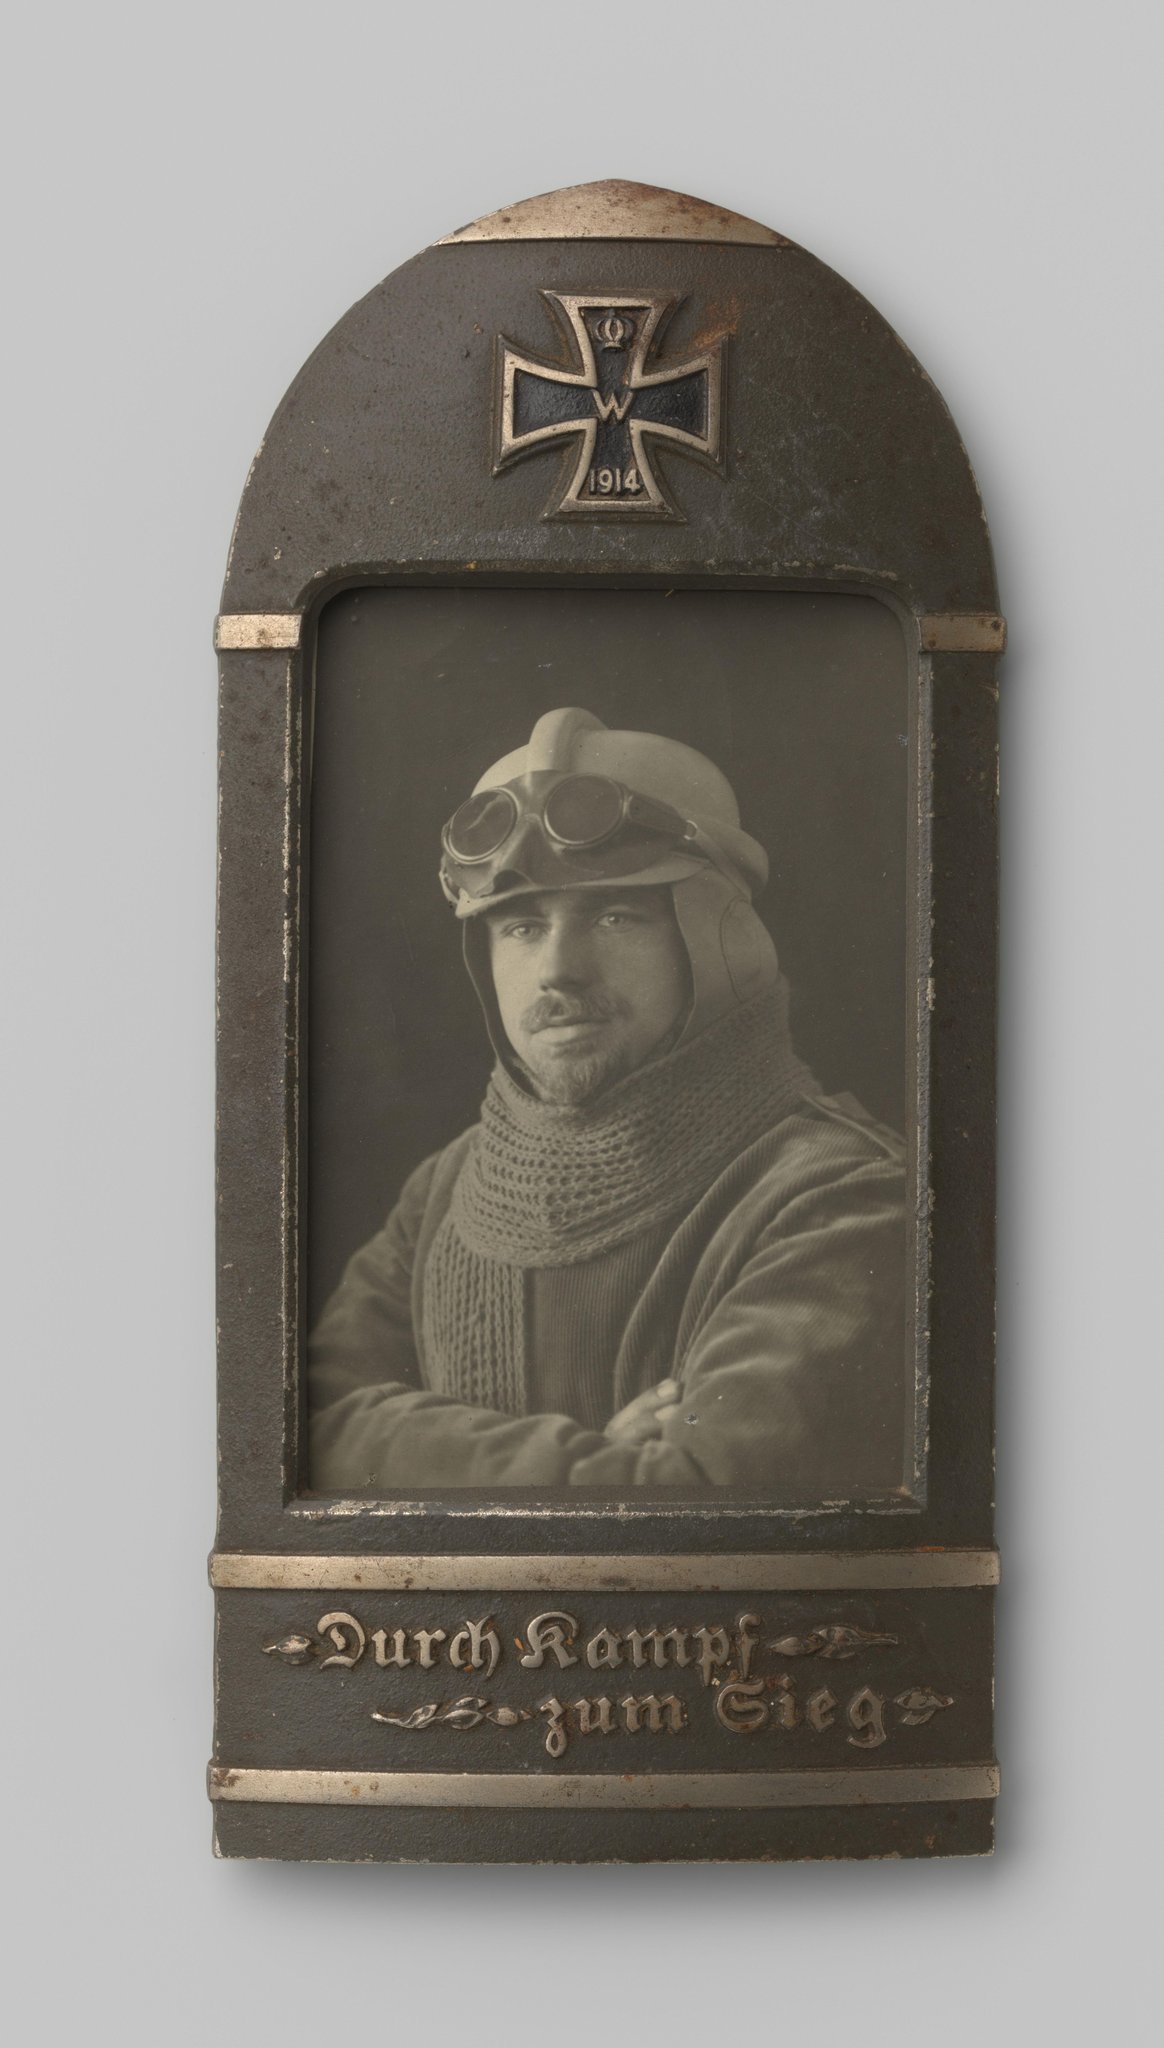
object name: photograph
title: Portret vliegenier met bril, helm in lijst met tekst 'Durch Kampf zum Sieg', in lijst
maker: Anonymous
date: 1914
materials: paper, cardboard, glass, metal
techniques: gelatin silver print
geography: germany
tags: pilot, anonymous historical person portrayed, germany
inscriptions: number: ‘183/ 2’